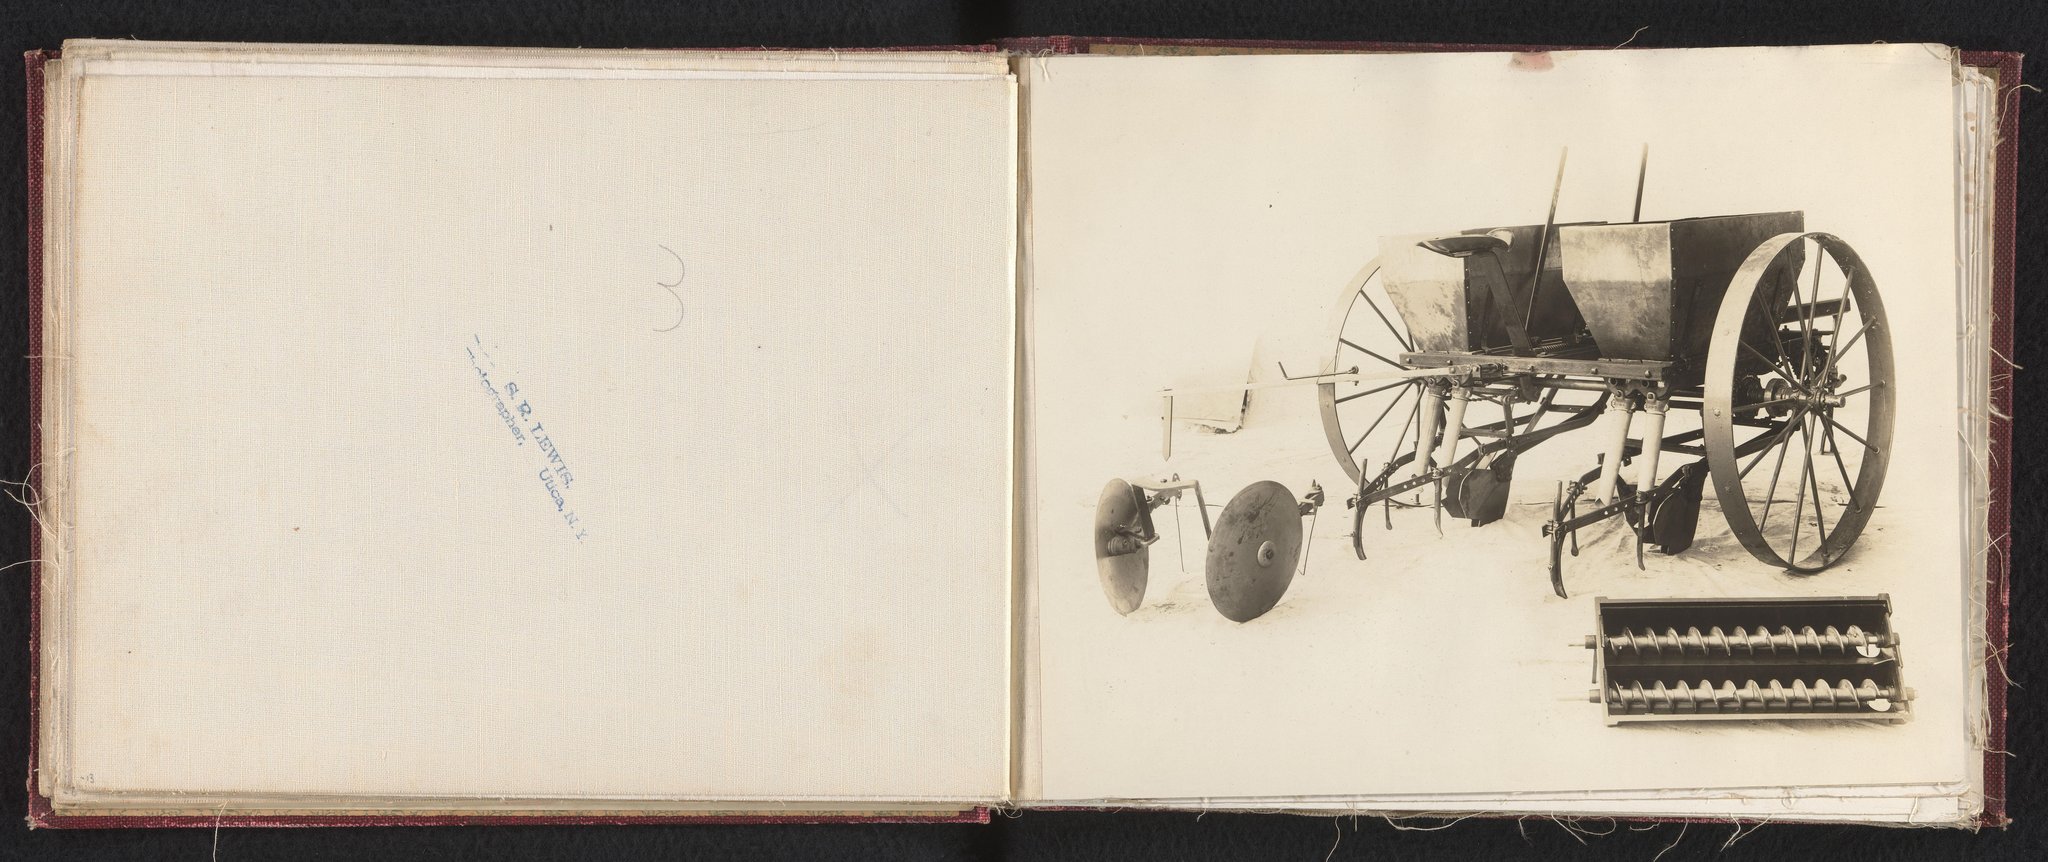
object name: photograph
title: Landbouwwerktuig met onderdelen, van de Eureka Mower Co. te Utrica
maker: lewis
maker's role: fotograaf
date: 1915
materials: paper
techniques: gelatin silver print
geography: utica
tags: agricultural implements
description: Foto op elfde ongenummerde pagina na voorplat.